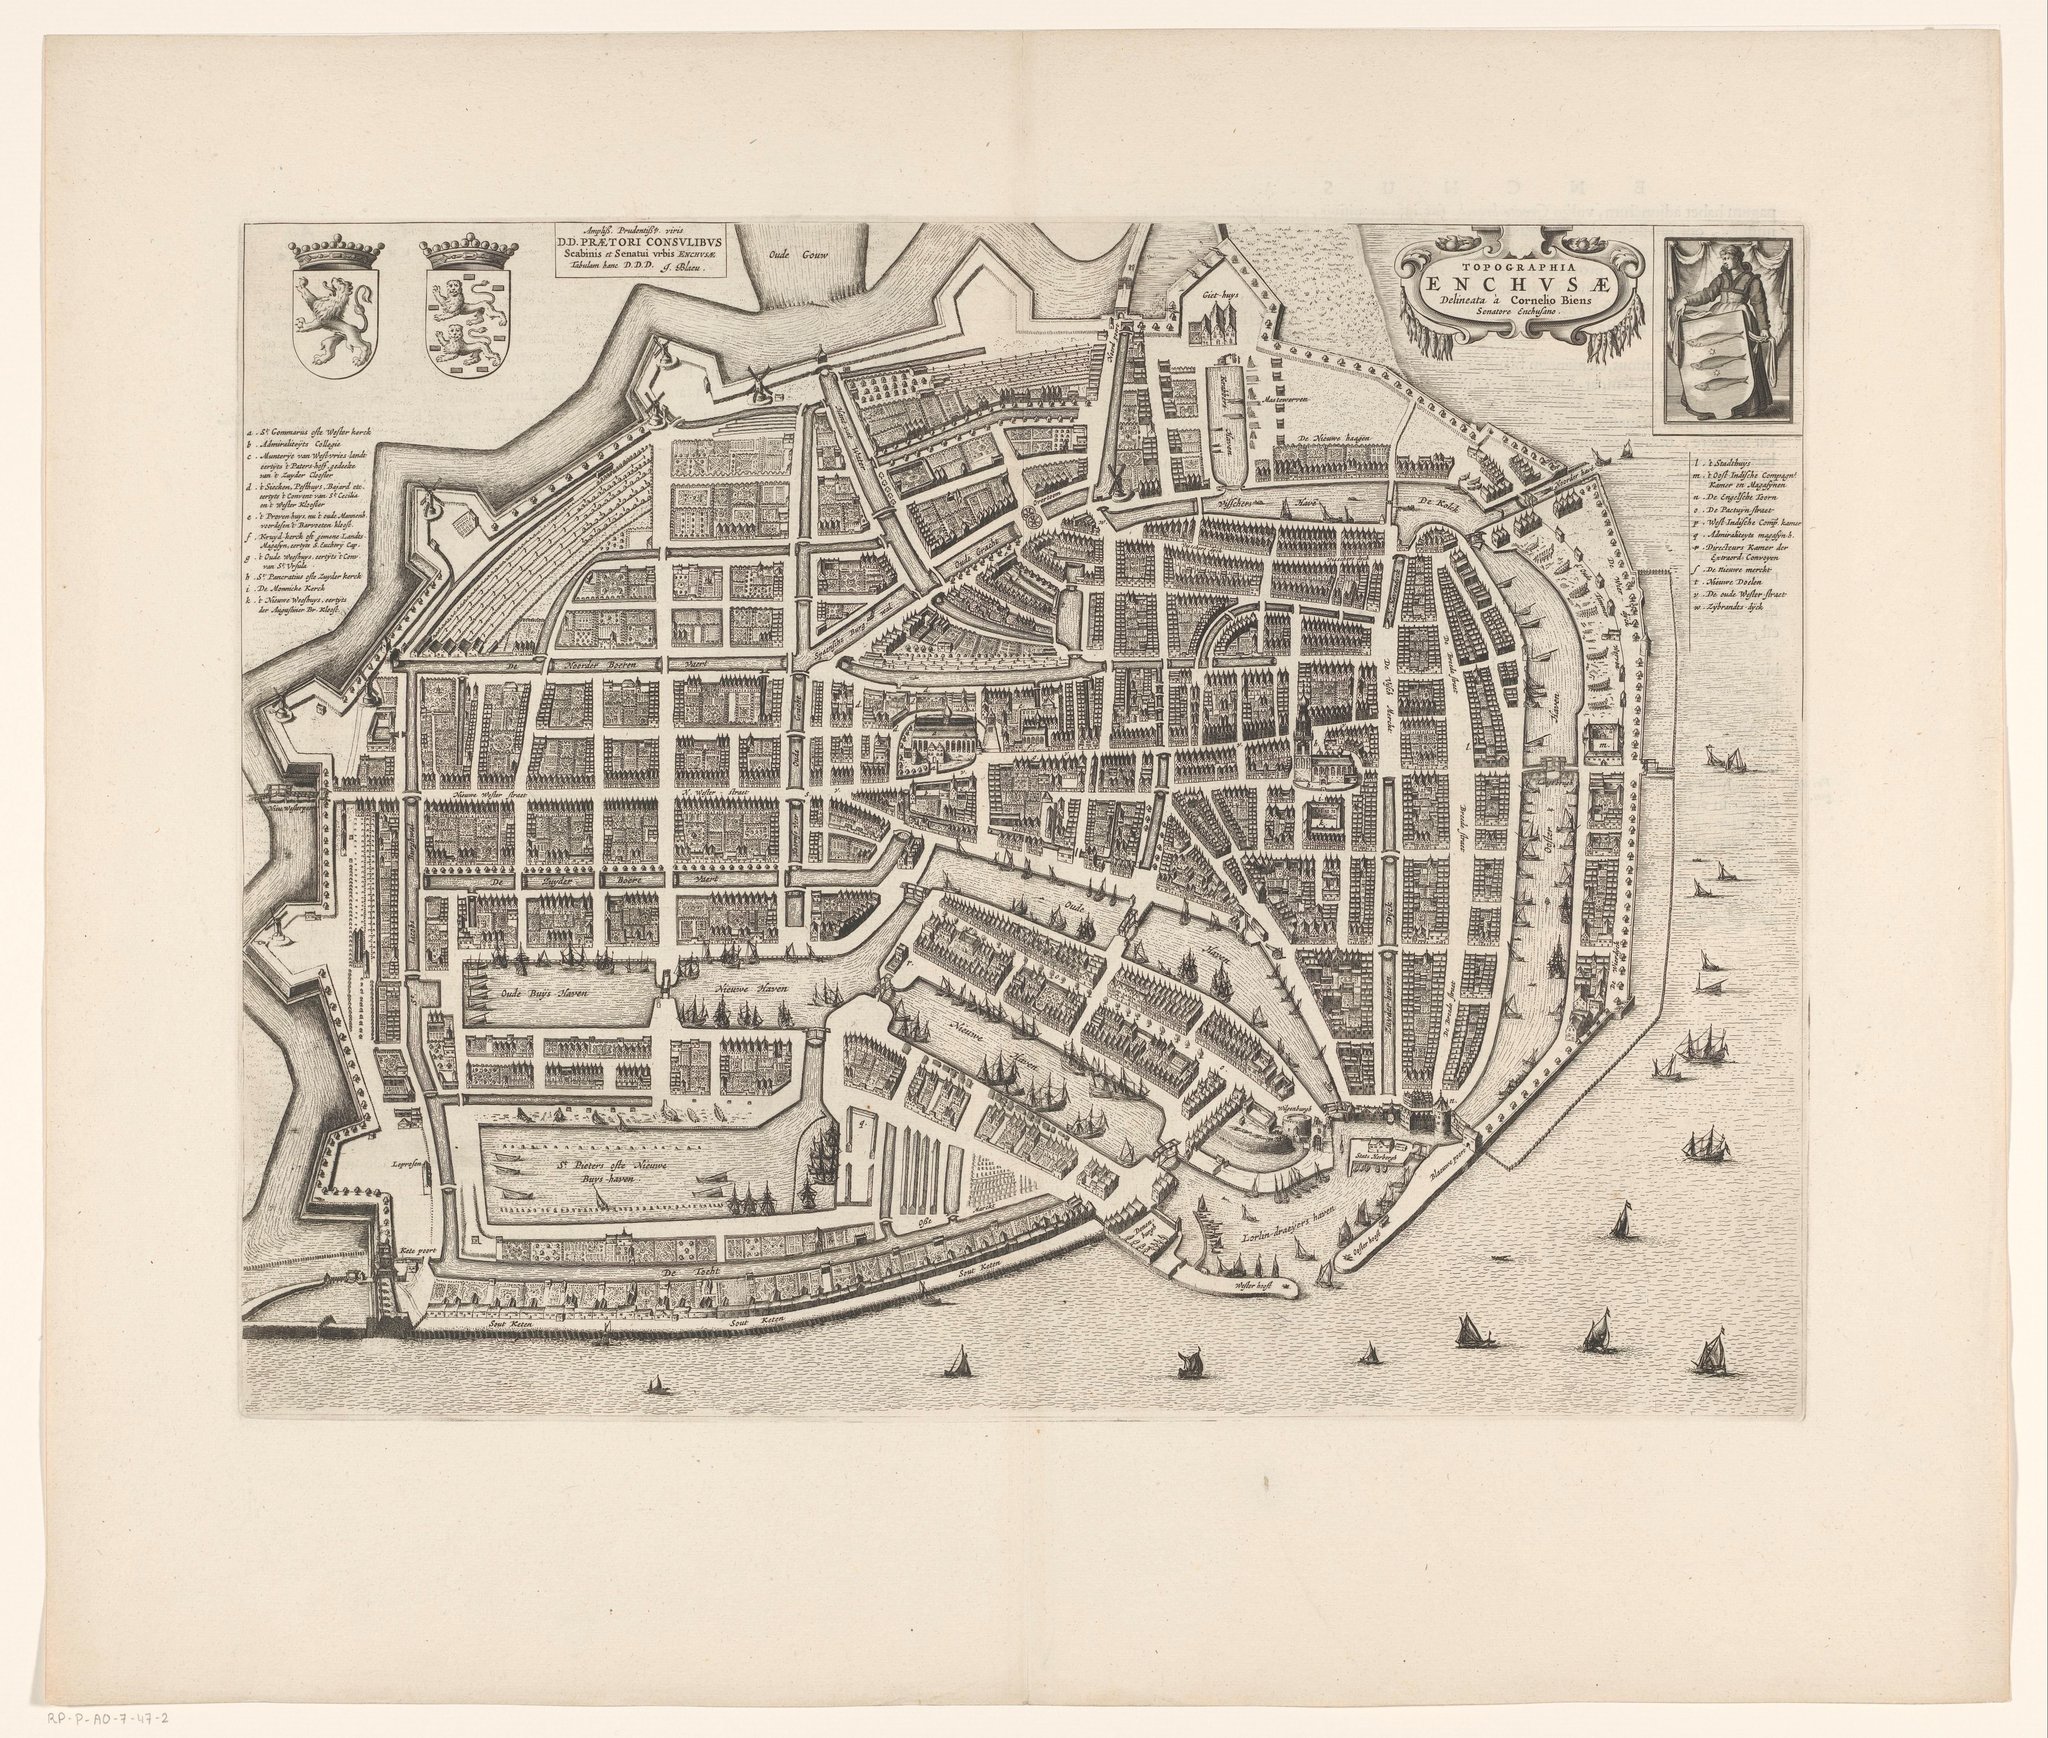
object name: area plan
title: Topographia Enchusae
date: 1652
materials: paper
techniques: engraving, etching, letterpress printing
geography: enkhuizen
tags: coat of arms (as symbol of the state, etc.), coat of arms (as symbol of the state, etc.) (+ city; municipal), maps of cities, enkhuizen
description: Plattegrond in vogelvluchtperspectief. Linksboven de wapens van Holland en West-Friesland, daaronder een legenda. Rechtsboven de titelcartouche en het wapen van Enkhuizen. Daaronder nog een legenda. Op verso Latijnse tekst.